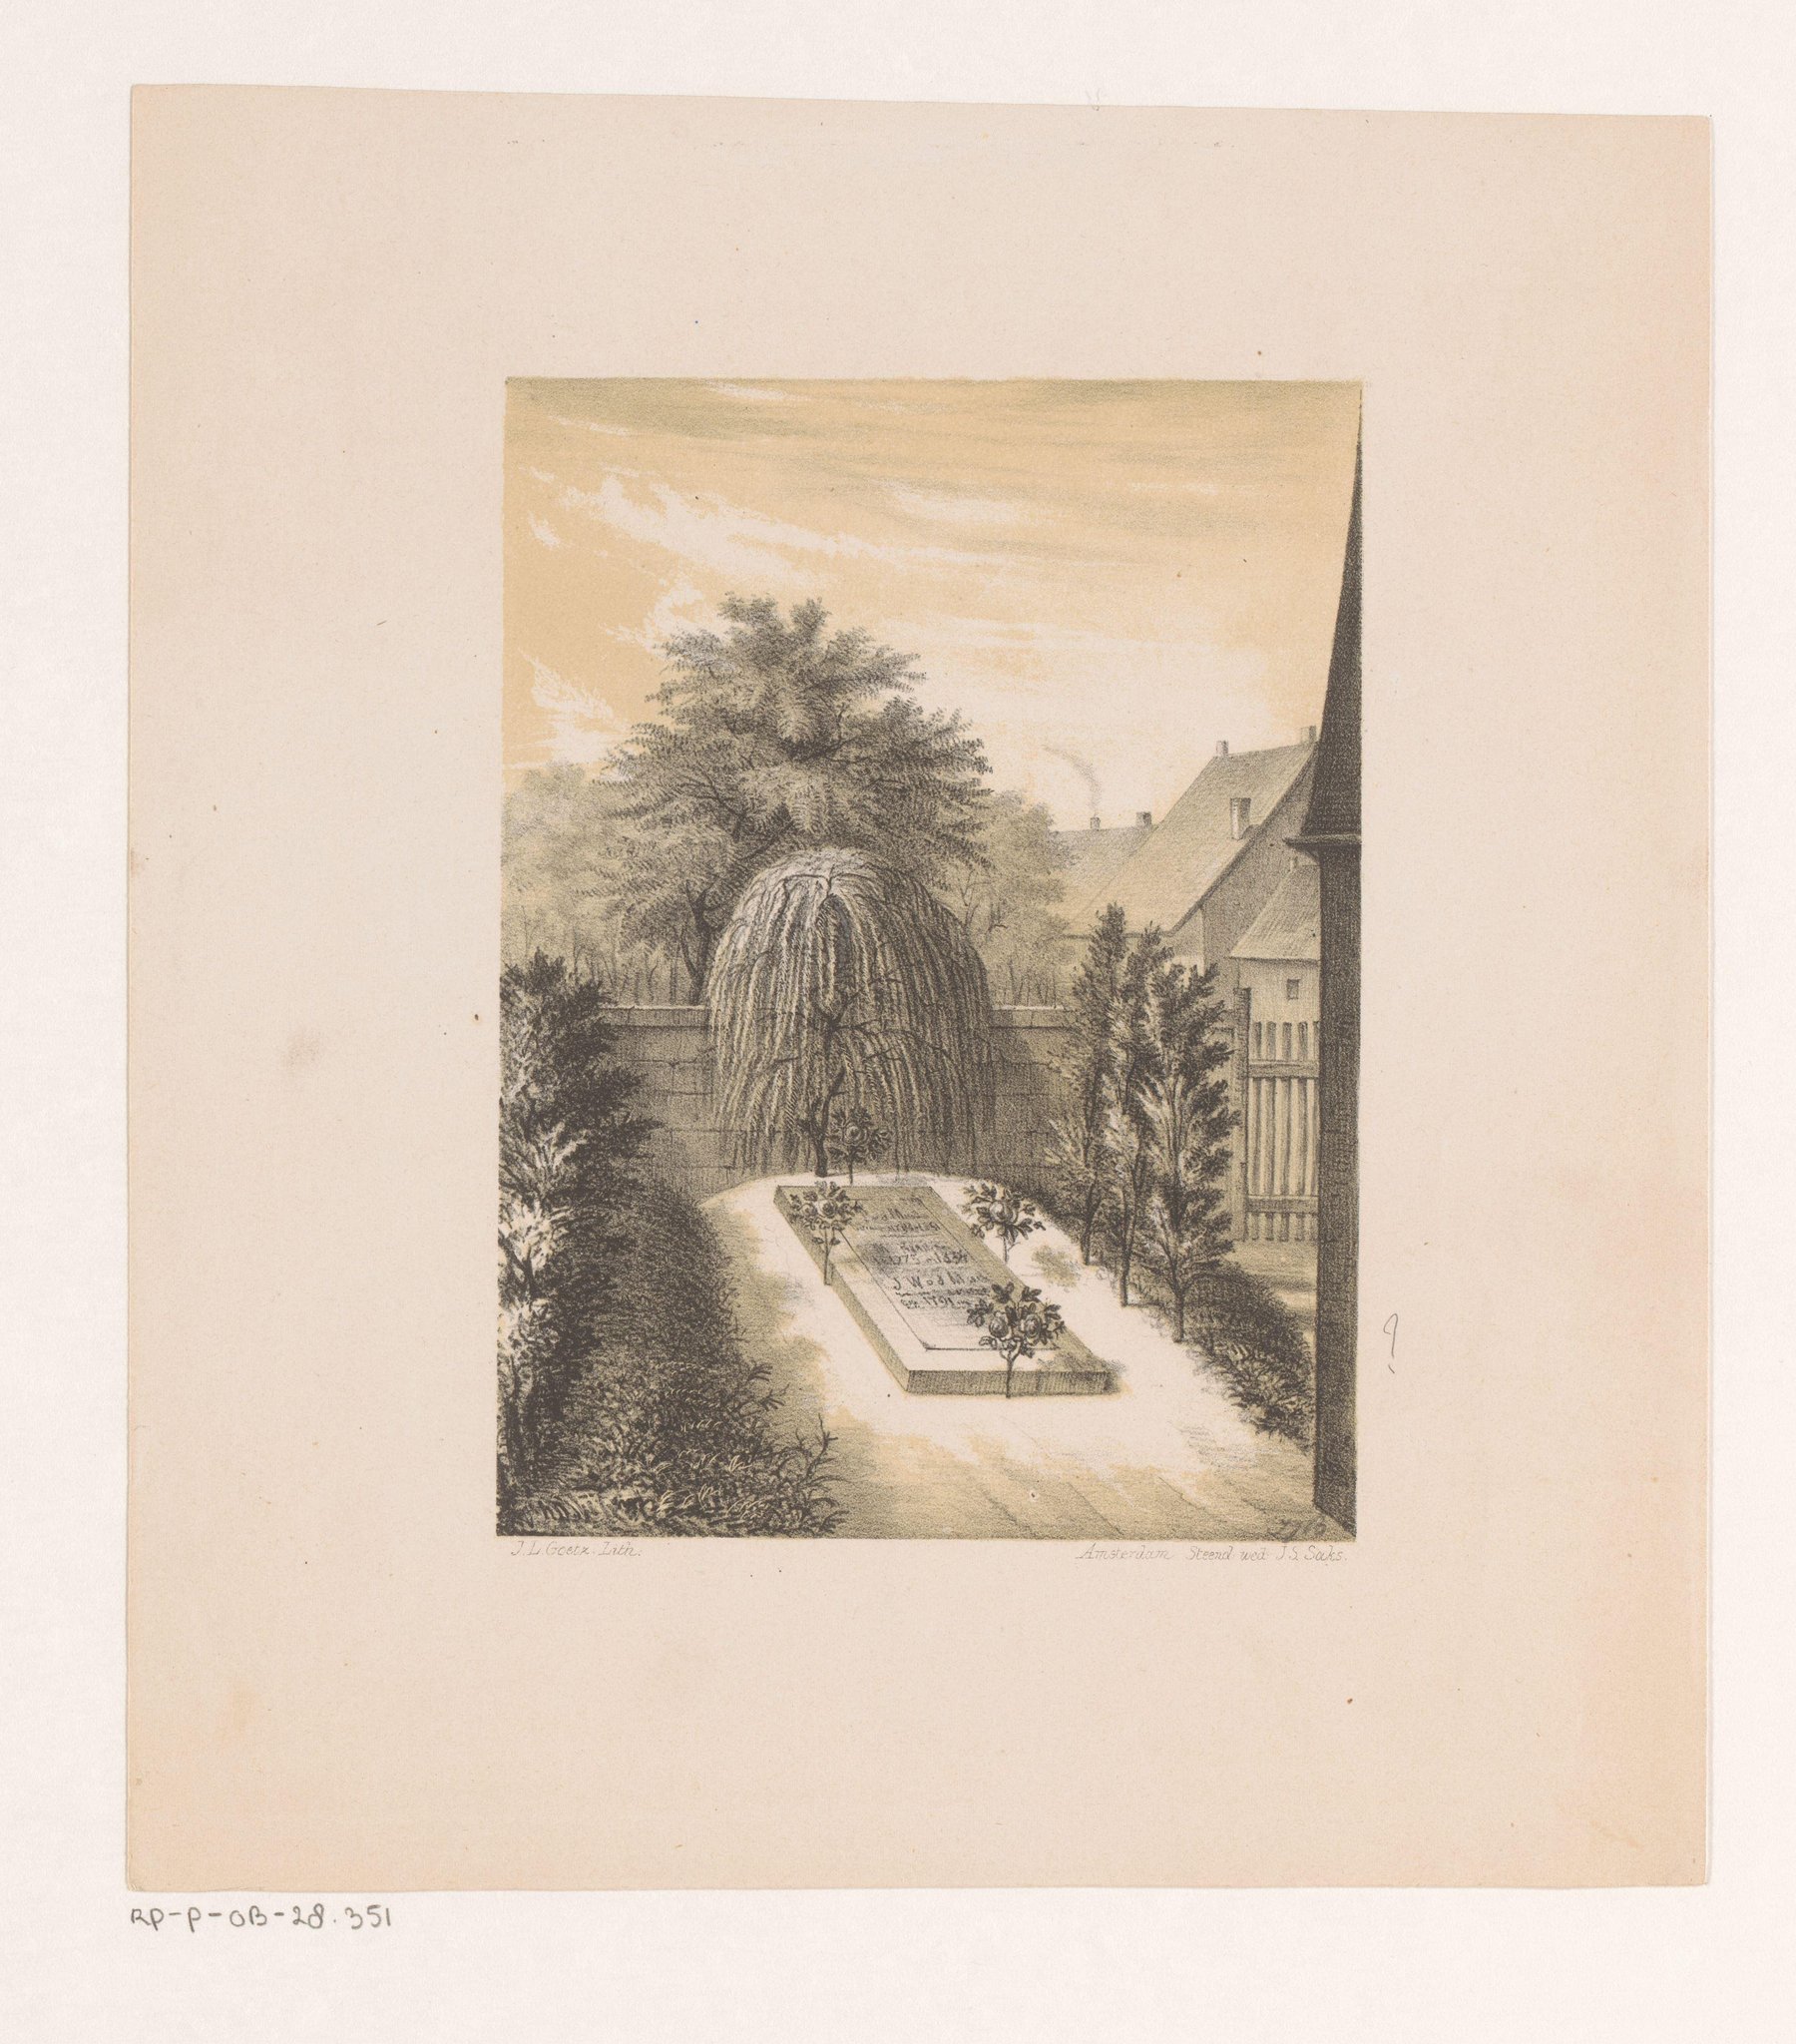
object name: print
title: Graf van Johanna Wilhelmina van der Meulen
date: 1856-1867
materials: paper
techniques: tone lithography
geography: amsterdam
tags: gravestone, tombstone, trees: willow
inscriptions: collector's mark: Lugt 2228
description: Aan het hoofd van het graf staat een treurwilg.